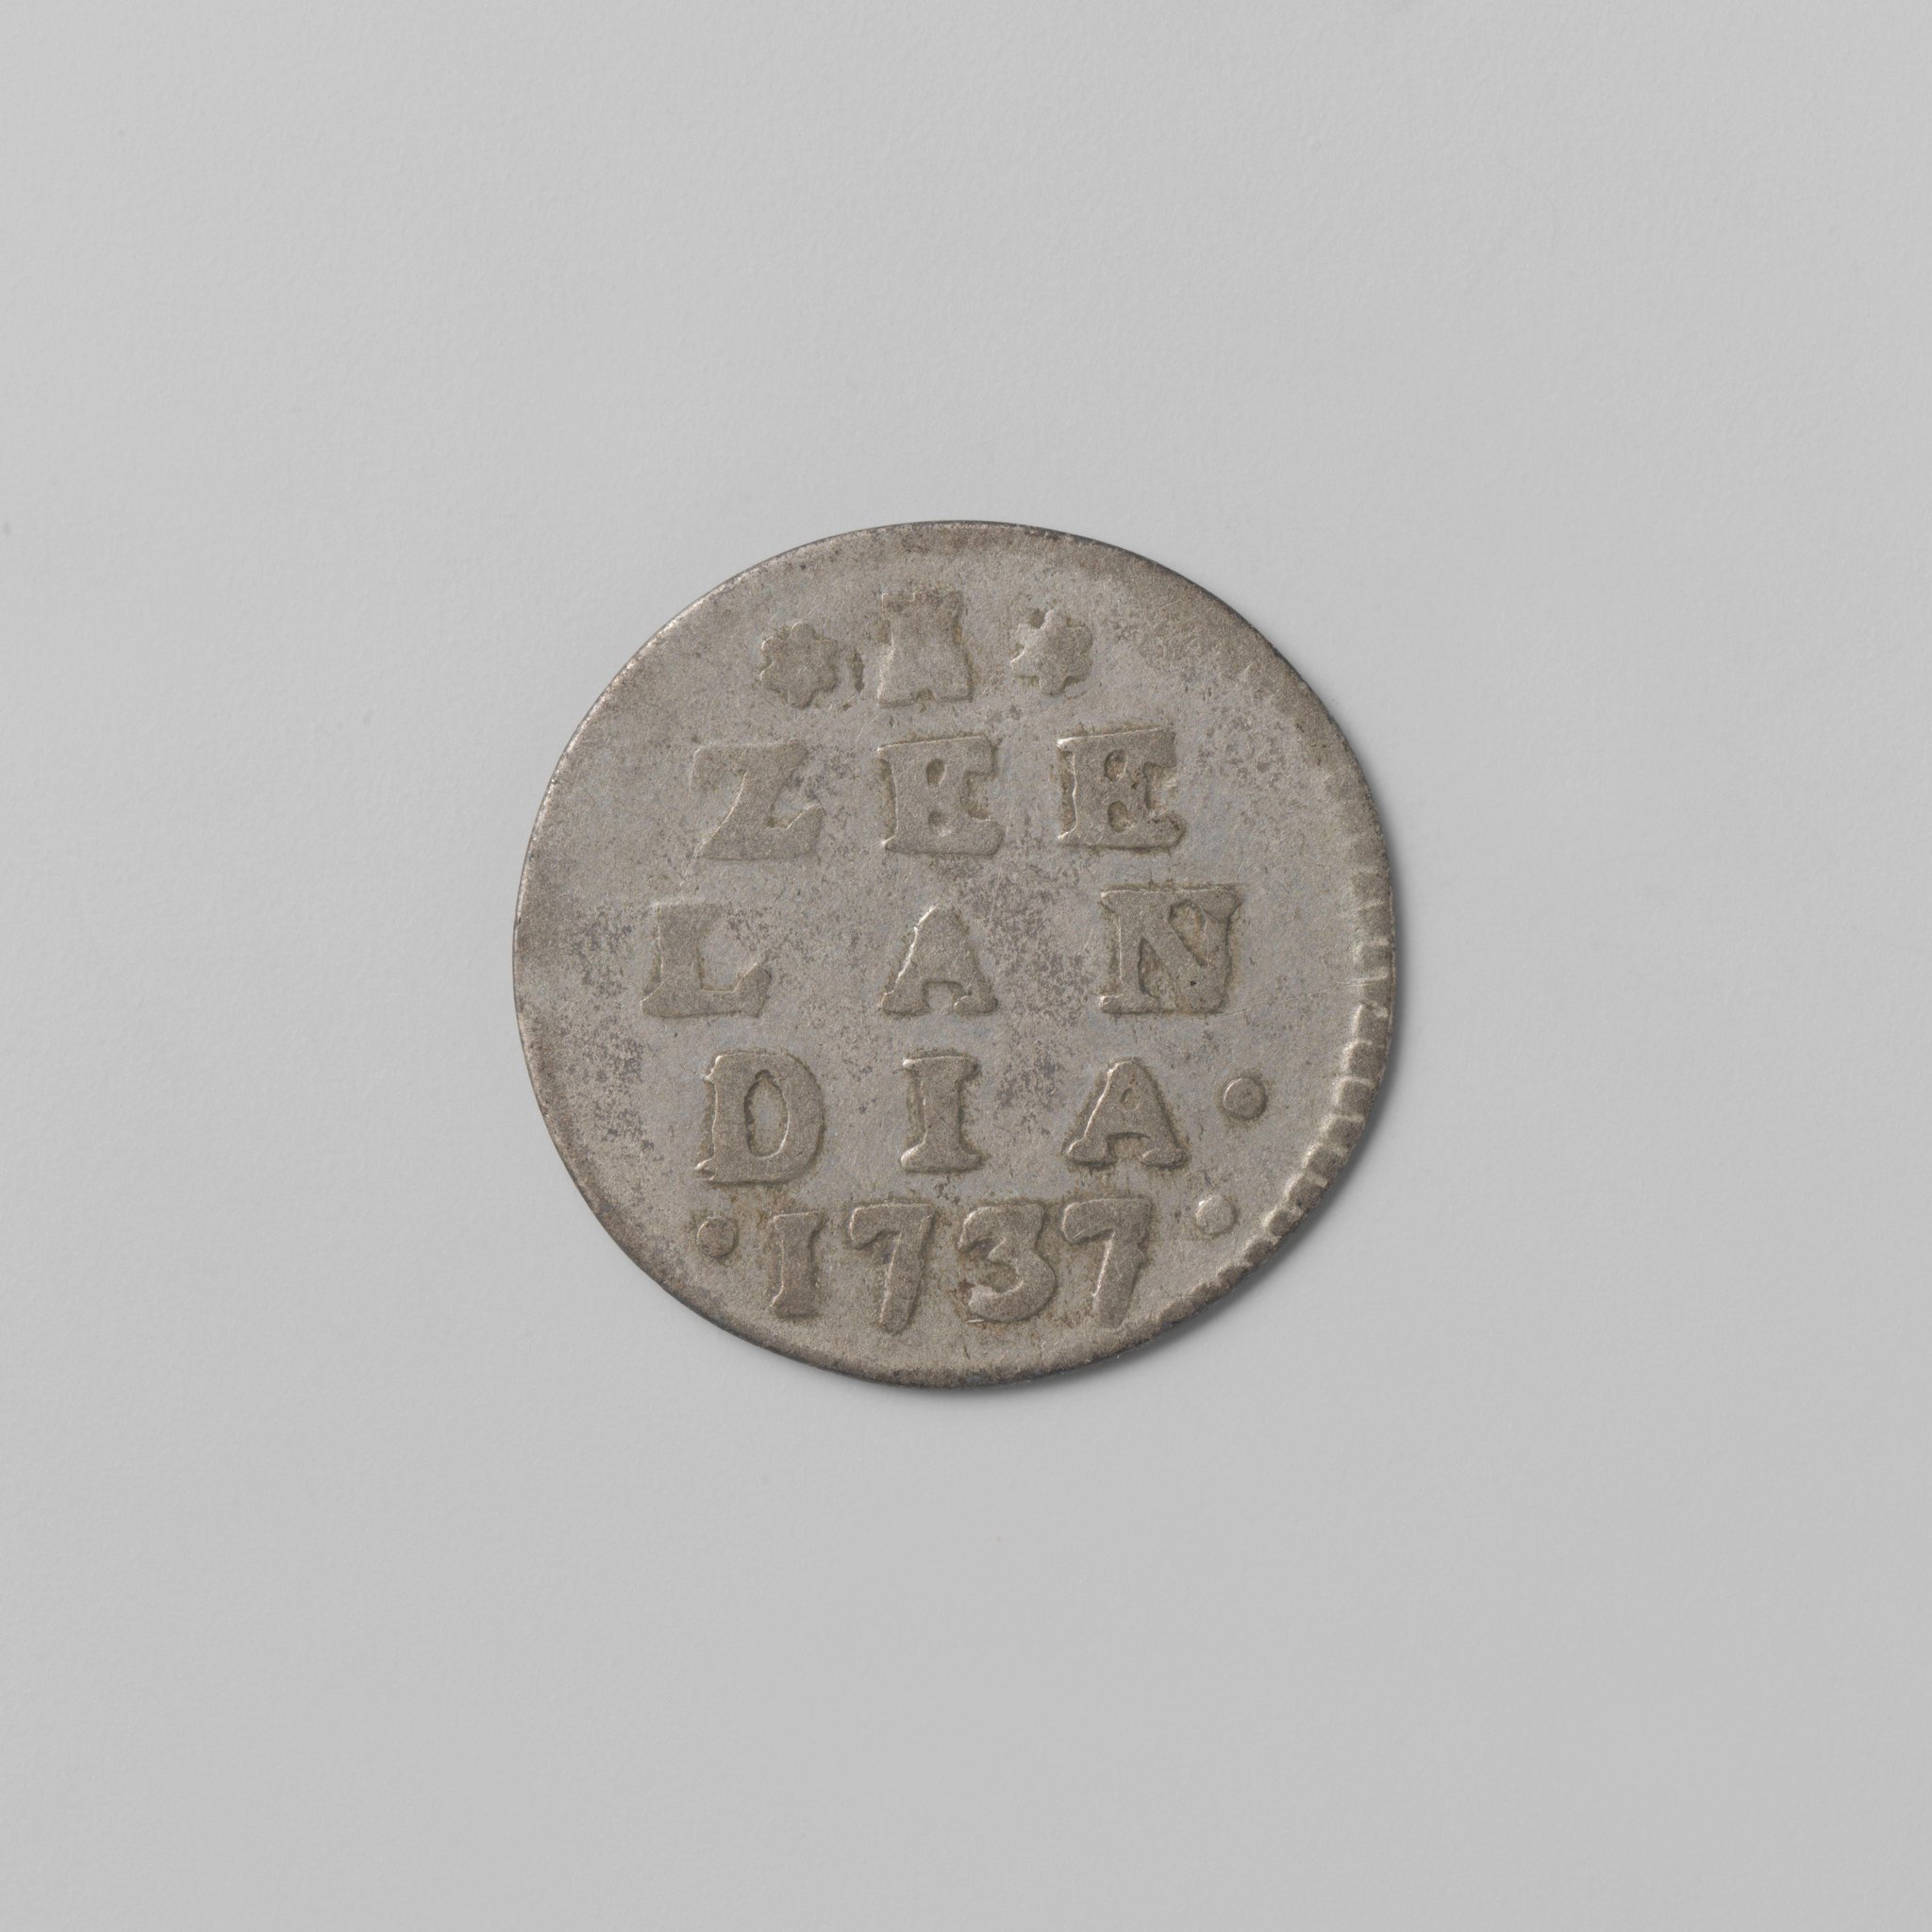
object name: coin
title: Zeeuwse dubbele stuiver, 1737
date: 1737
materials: silver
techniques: striking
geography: middelburg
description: Zilveren munt. Voorzijde: tussen waarde-aanduiding 2 S gekroond wapenschild van Zeeland. Keerzijde: opschrift in drie regels, waarboven muntteken burcht tussen twee rozetten en waaronder jaartal.